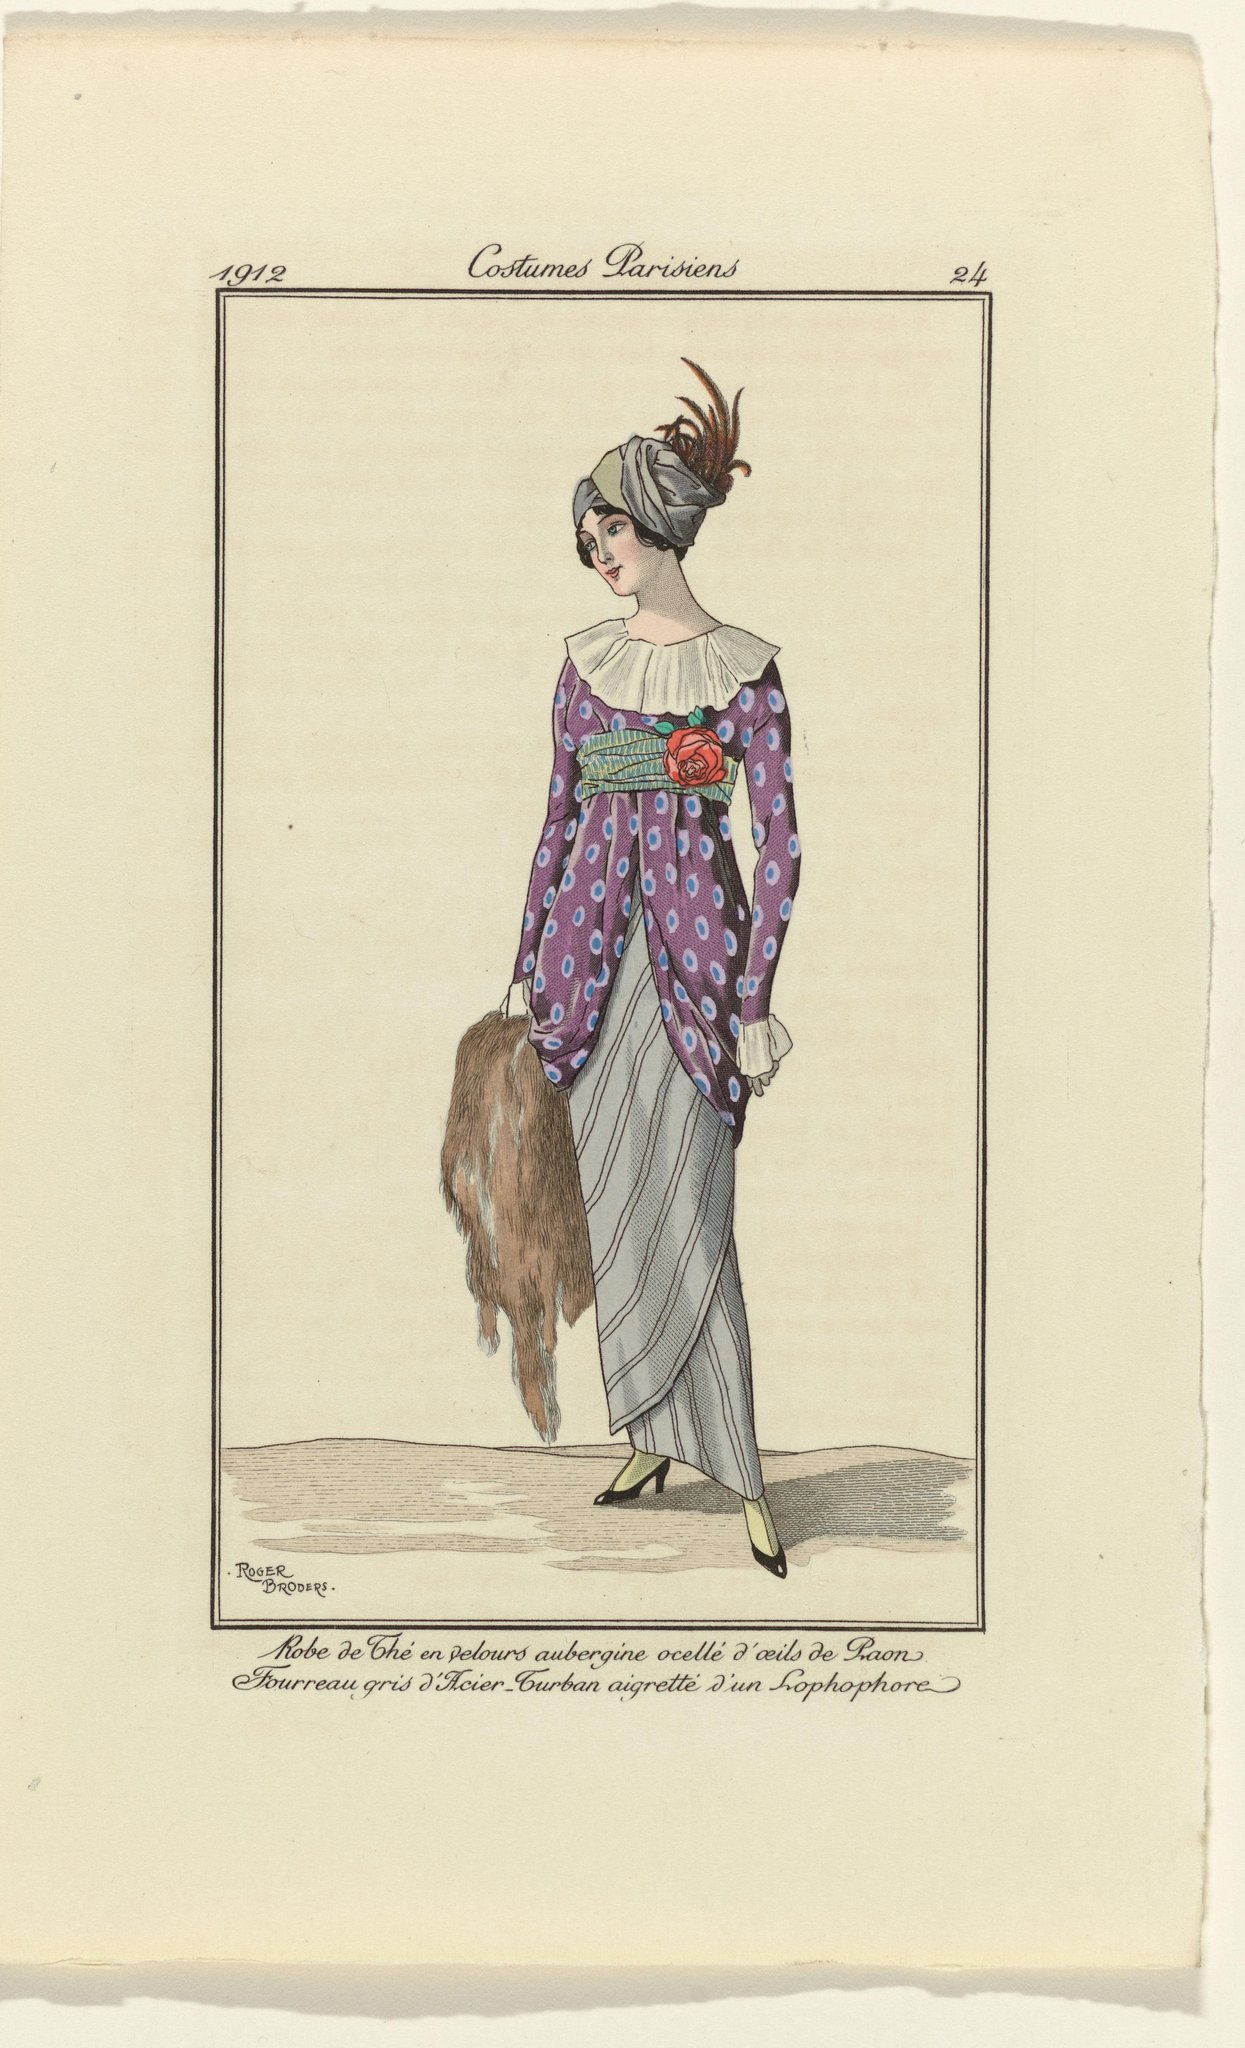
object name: fashion print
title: Journal des Dames et des Modes, 1912, Costumes Parisiens, no. 24: Robe de Thé (...)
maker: roger broders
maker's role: illustrator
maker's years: 1883-1953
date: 1912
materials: paper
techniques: engraving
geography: paris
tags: fashion plates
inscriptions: caption: ‘Robe de promenade en Sarah à damiers et taffetas peint à la main, bordée de velours noir: Chapeau de paille orné d'un panache en duvet de Cygne’